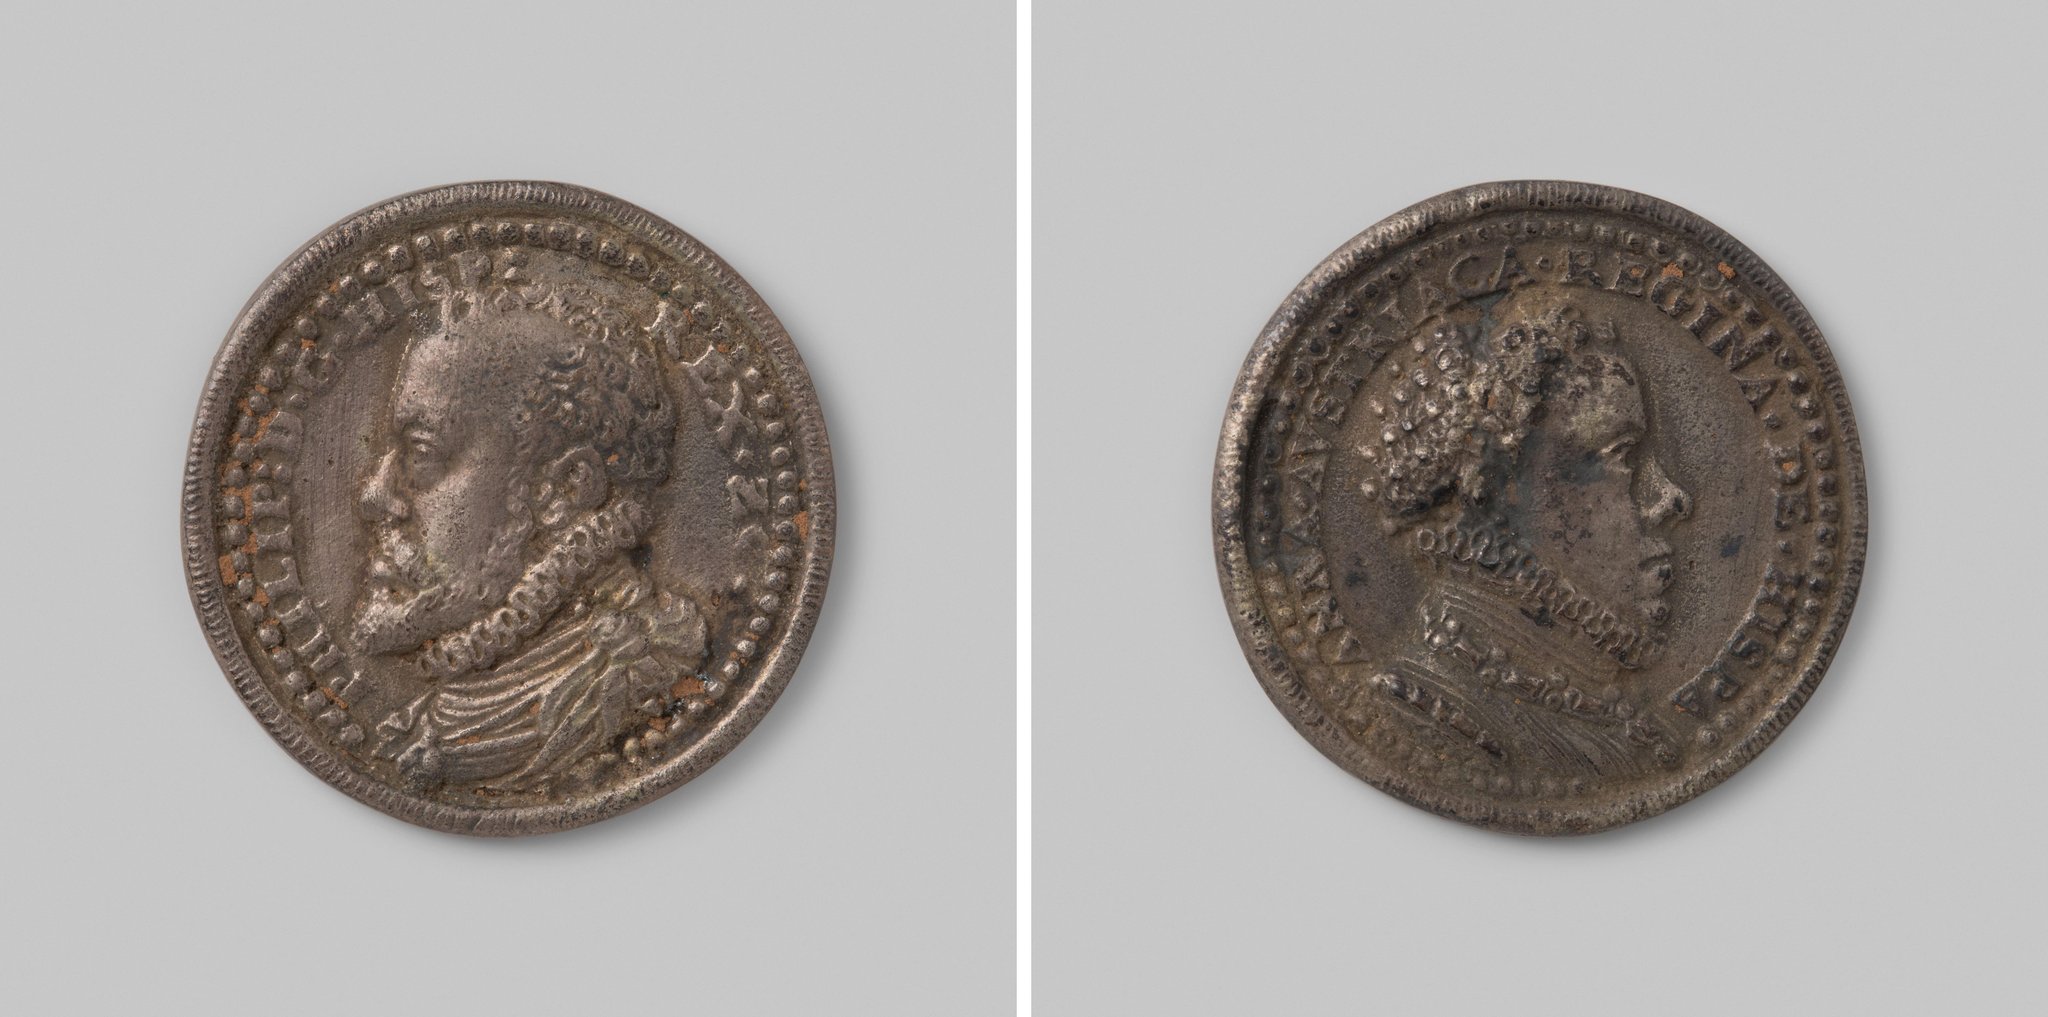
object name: copy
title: Huwelijk van Filips II van Spanje en Anna van Oostenrijk, dochter van Maximiliaan II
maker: Anonymous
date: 1570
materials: silver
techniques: casting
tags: philip ii of spain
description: Zilveren penning. Voorzijde: borststuk man binnen omschrift. Keerzijde: borststuk vrouw binnen omschrift.